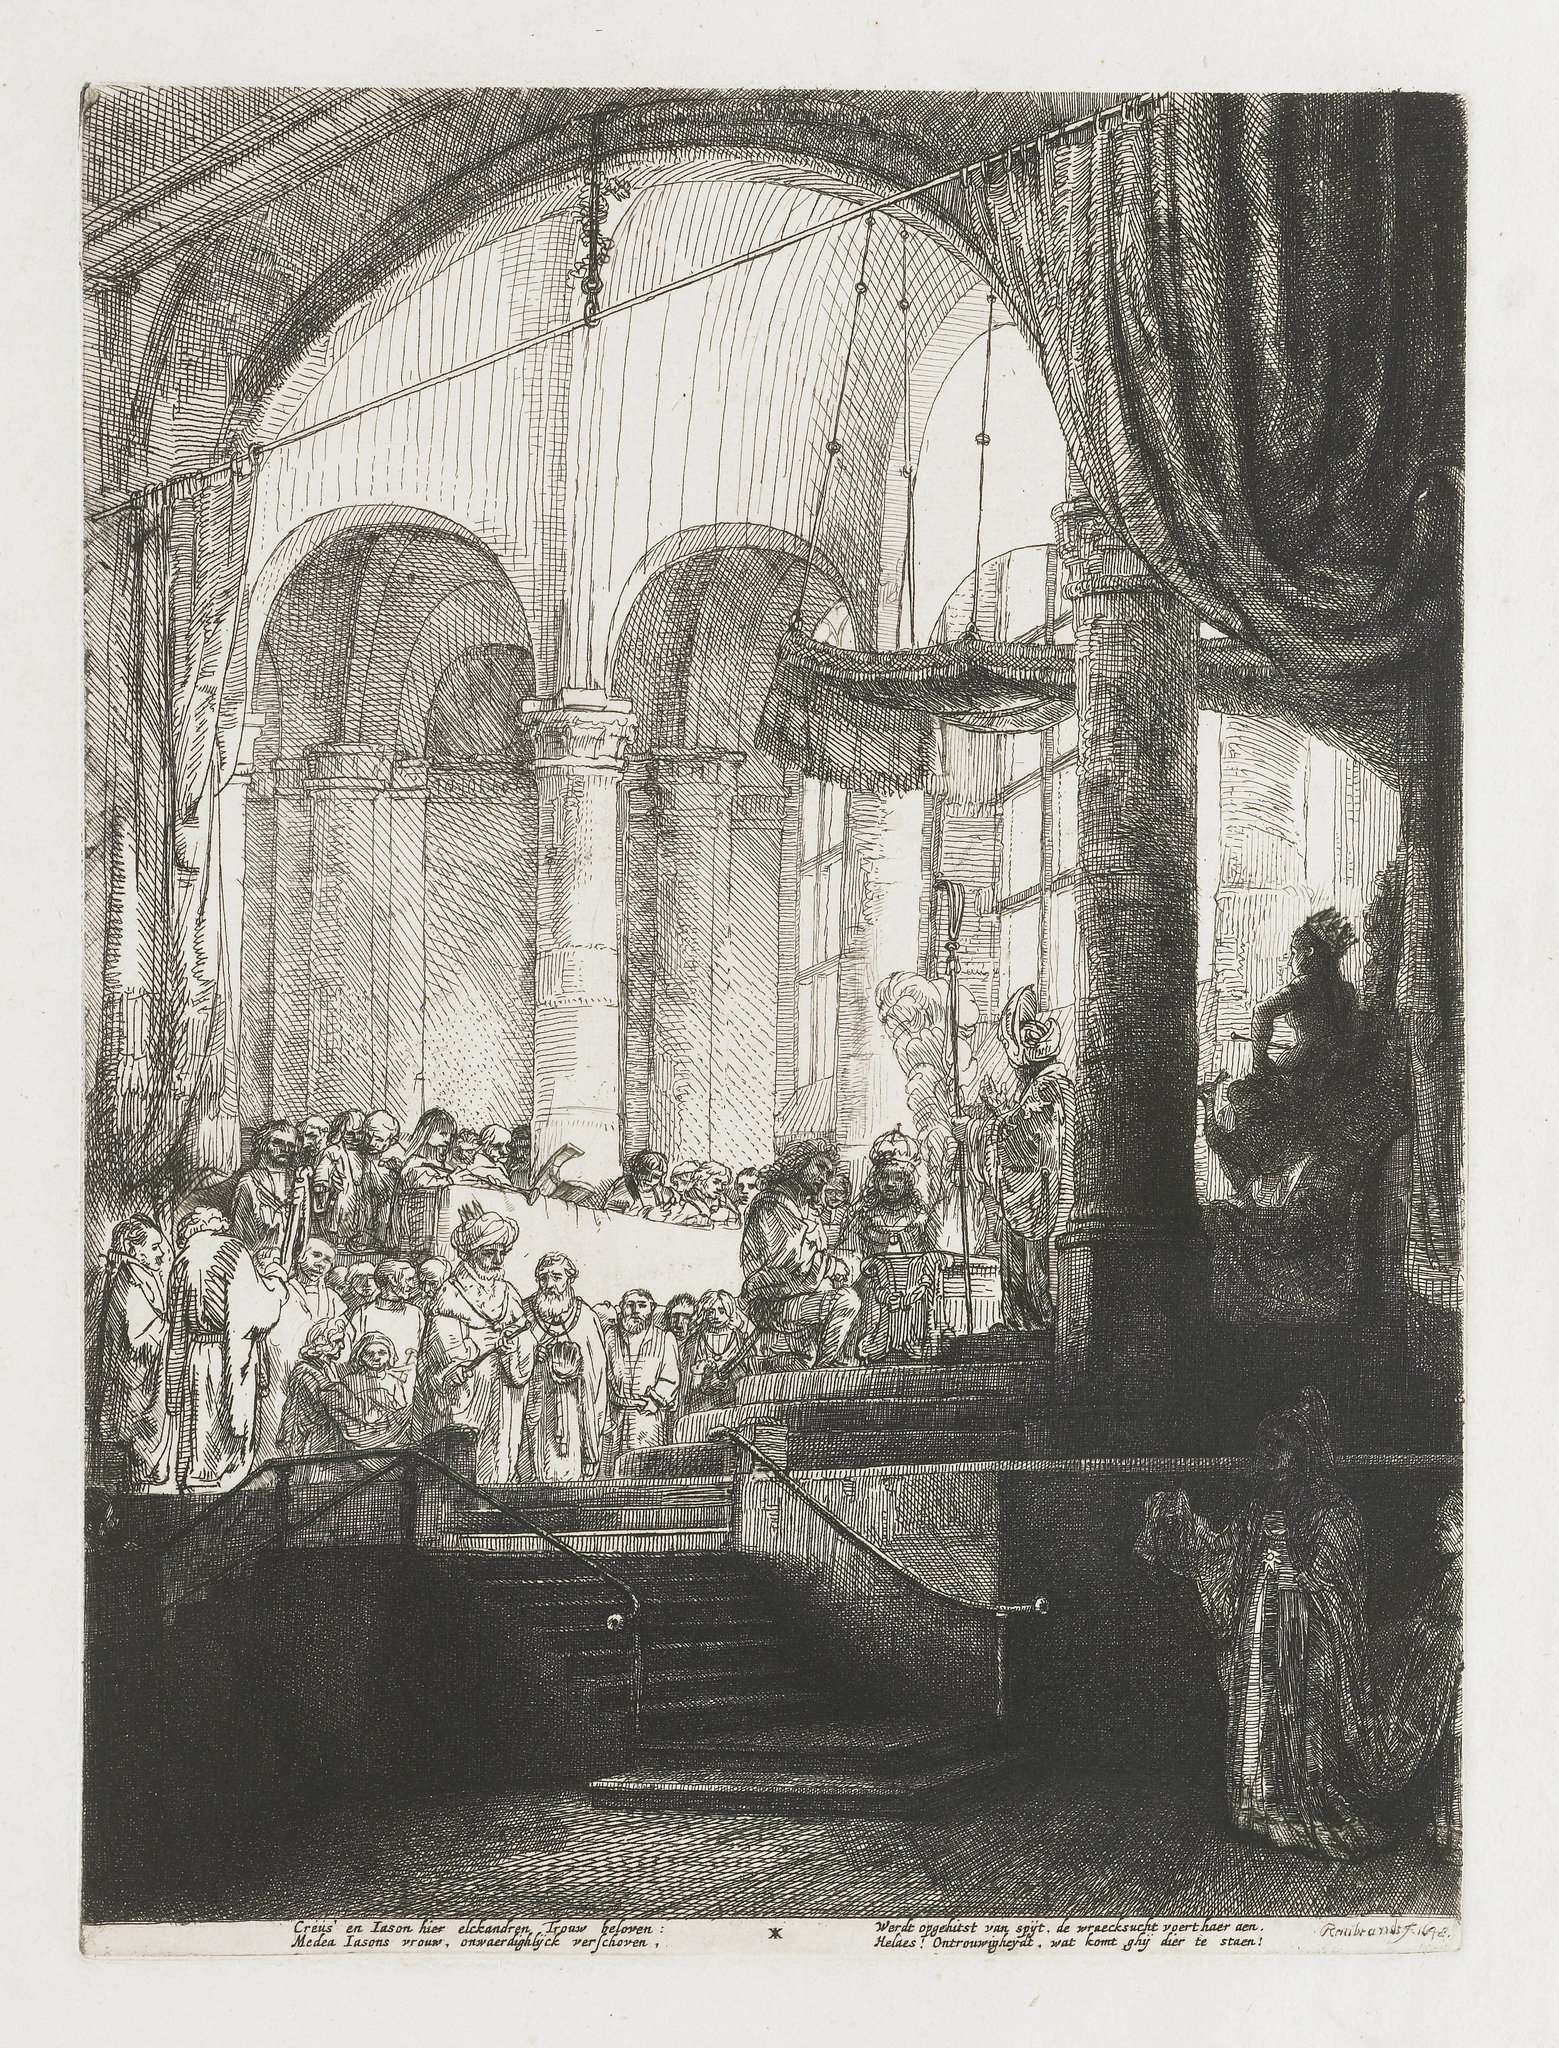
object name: print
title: Medea: or the marriage of Jason and Creusa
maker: rembrandt van rijn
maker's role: draughtsman, painter, print maker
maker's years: 1606-1669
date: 1648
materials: paper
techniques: drypoint, etching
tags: marriage of jason and creusa (glauce); possibly with medea watching the scene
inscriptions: collector's mark: Lugt 240, signature and date: ‘Rembrandt f. 1648’, caption: ‘vierregelig vers’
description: Written by Jan Six, the tragedy Medea premiered in 1647. Rembrandt designed the title page for the printed play. The scene he depicted, incidentally, does not appear in it: he only summarized the plot. In the right foreground is Medea, abandoned by her husband, Jason, who marries Princess Creusa on the dais above. Medea wrought gruesome vengeance on them.